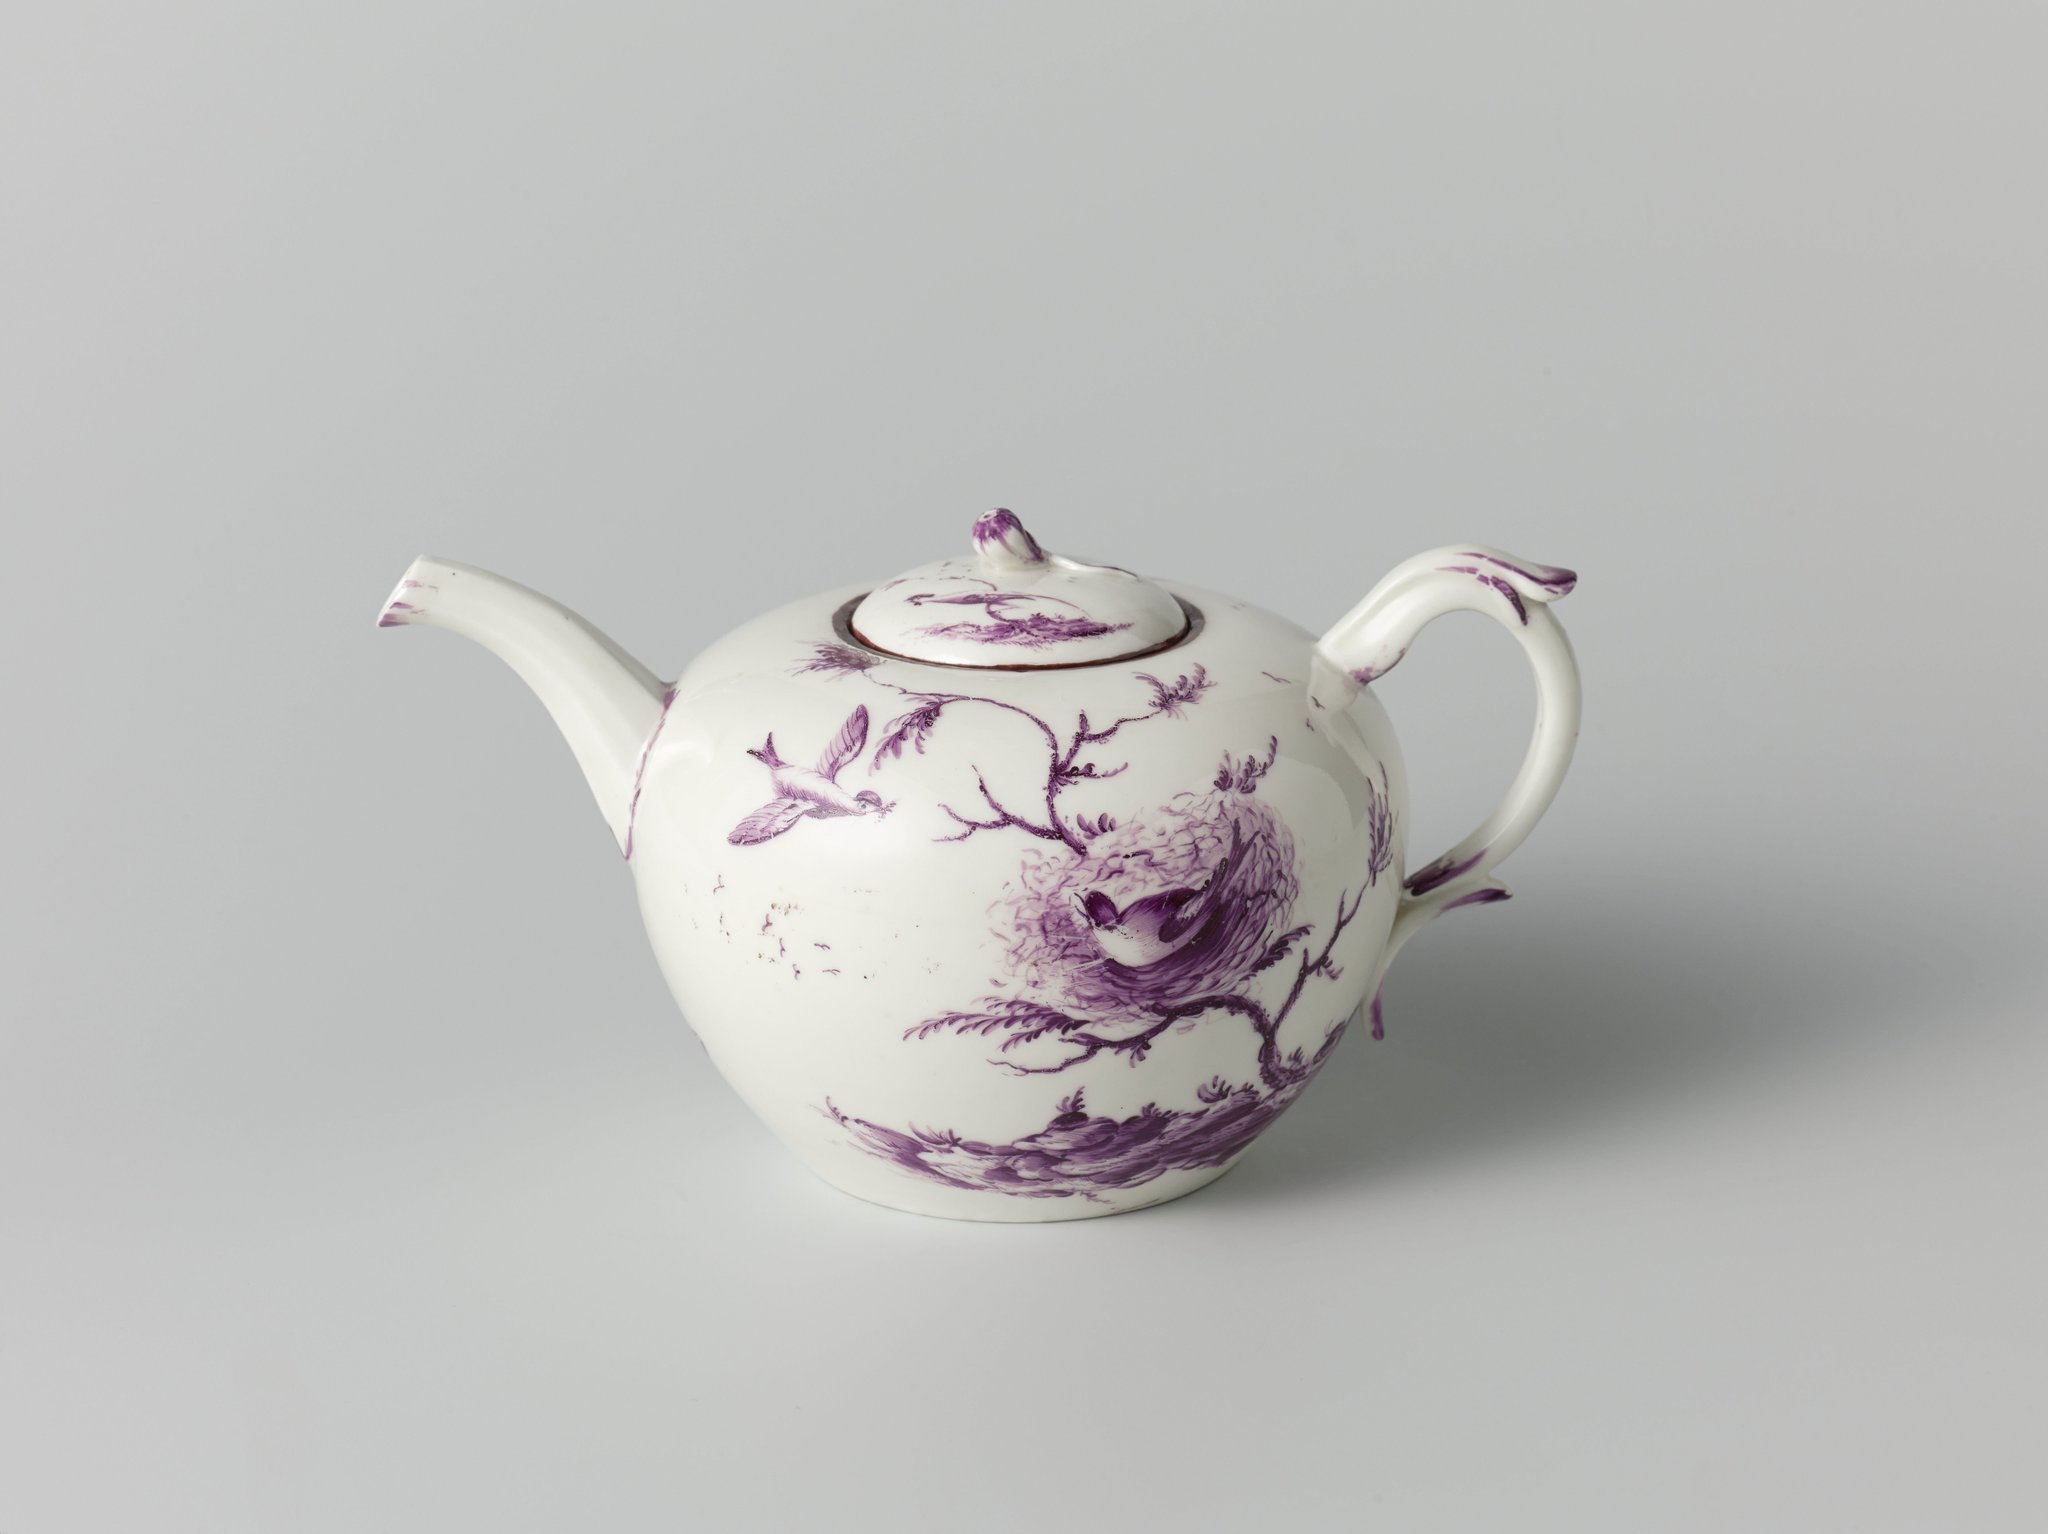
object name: teapot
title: Theepot, beschilderd met bomen en vogels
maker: louis victor gerverot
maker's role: ceramicist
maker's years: 1747-1829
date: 1774-1778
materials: porcelain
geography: loosdrecht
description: Tea pot. Porcelain. Loosdrecht, c. 1774 - 1778. Factory of Joannes de Mol, the decoration attributed to Louis Victor Gerverot.